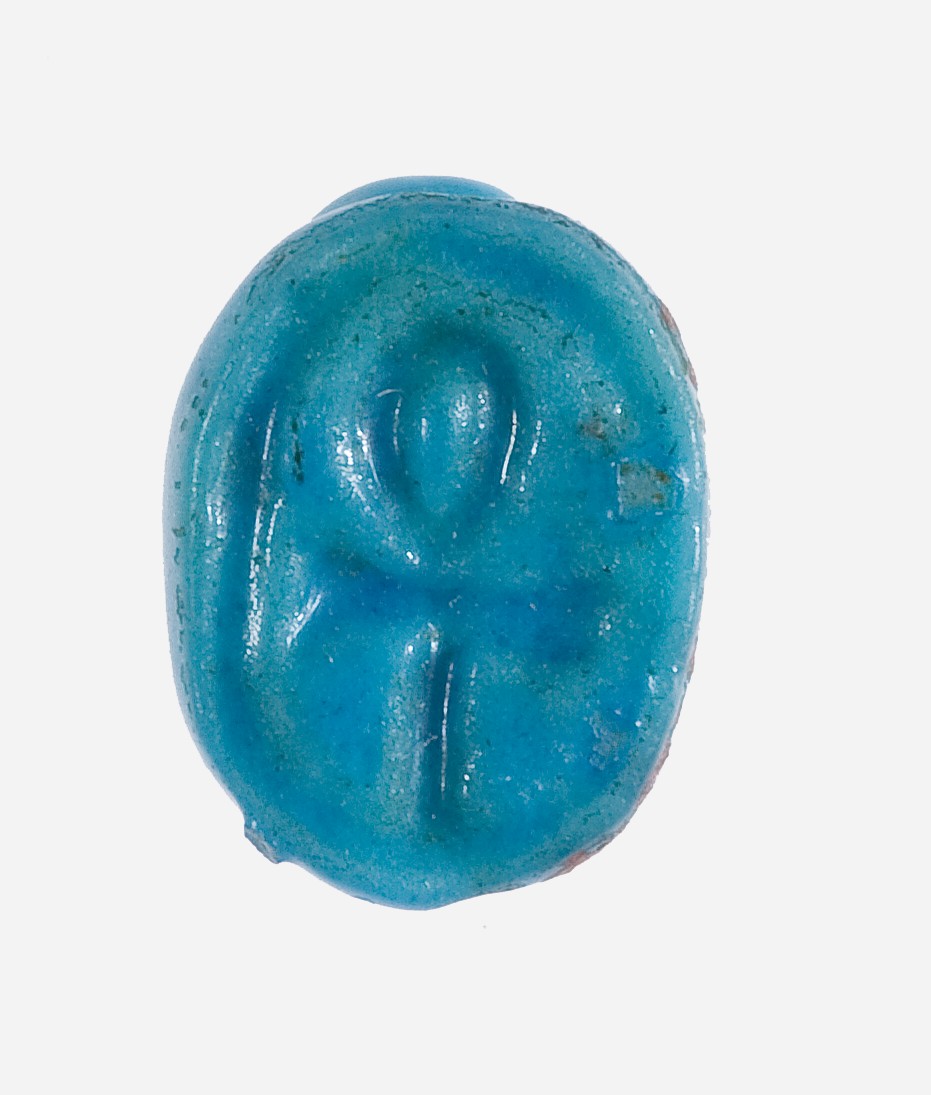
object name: scarab, ankh sign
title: Scarab Inscribed with an Ankh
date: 1390-1352 BCE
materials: faience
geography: egypt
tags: scarabs,ankh